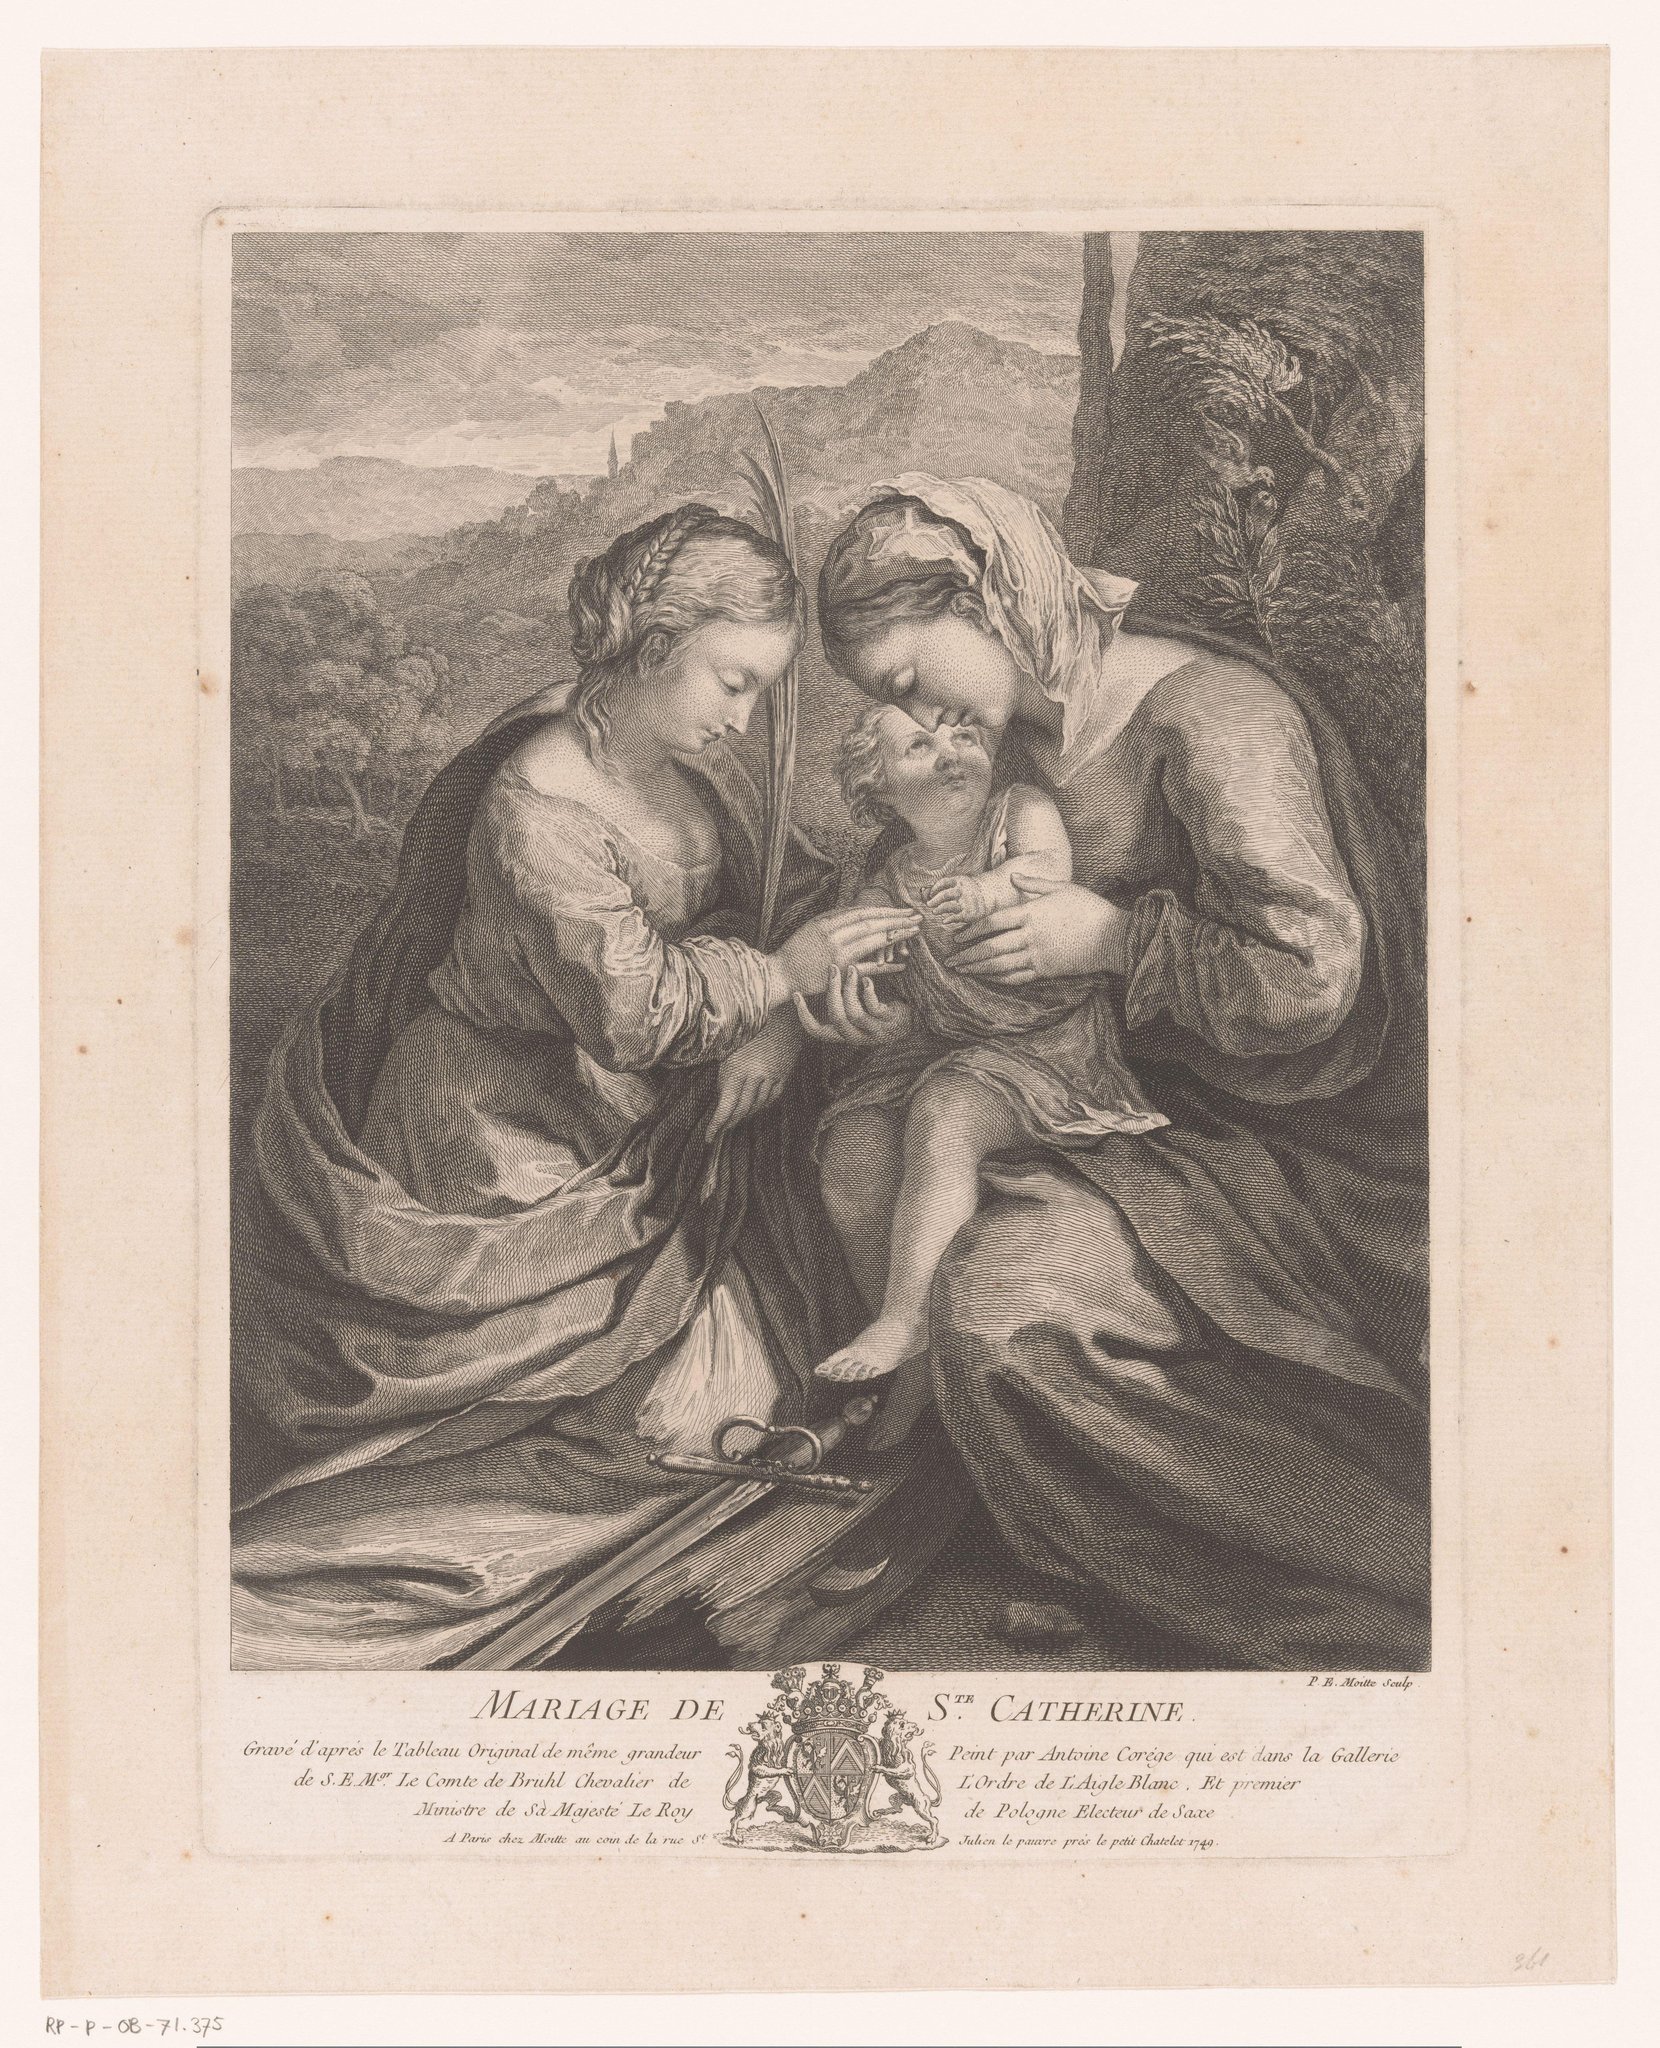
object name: print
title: Mystieke huwelijk van H. Catharina van Alexandrië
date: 1749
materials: paper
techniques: engraving, etching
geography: paris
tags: the mystic marriage of st. catherine of alexandria with the infant christ: the christ-child puts a ring on her finger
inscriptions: collector's mark: Lugt 2228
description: Maakt deel uit van een serie getiteld 'Recueil d'estampes gravées d'après les tableaux de la galerie de S.E.M. le Comte de Brühl', met etsen naar schilderijen uit de collectie Brühl, uitgegeven in Dresden in 1754. Zie British Museum, inv.nr. 1850,0810.431.